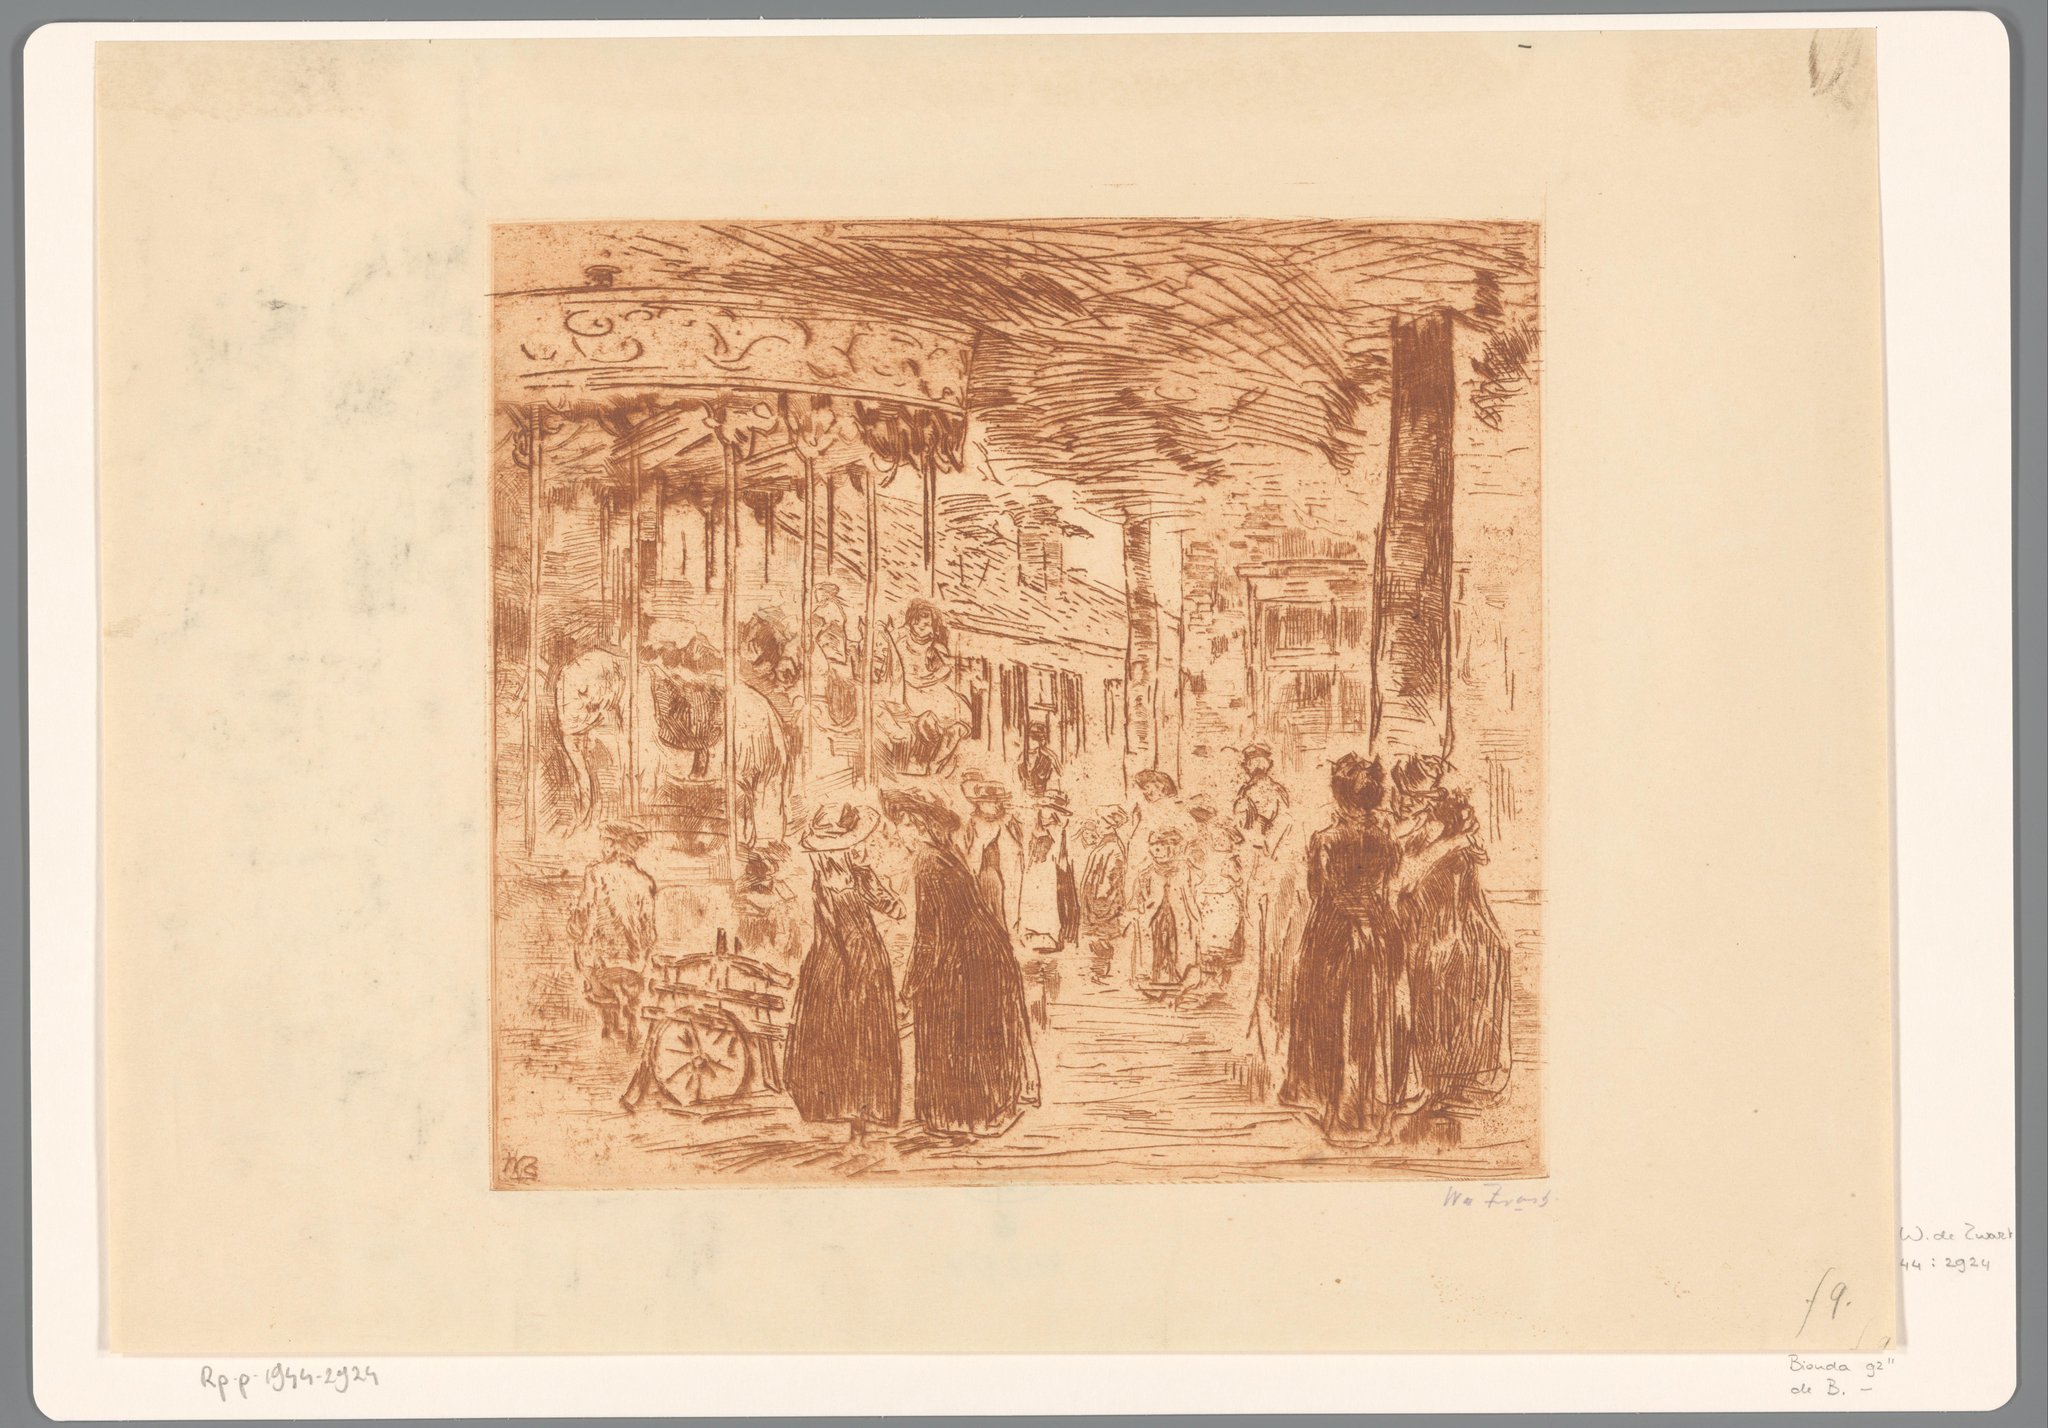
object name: print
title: Draaimolen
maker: willem de zwart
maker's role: draughtsman, painter, print maker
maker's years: 1862-1931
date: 1897-1898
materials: paper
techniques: drypoint, etching, intaglio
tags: merry-go-round, roundabout; chair o'plane, pleasure fair and circus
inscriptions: collector's mark: Lugt 2760, collector's mark: Lugt 2228